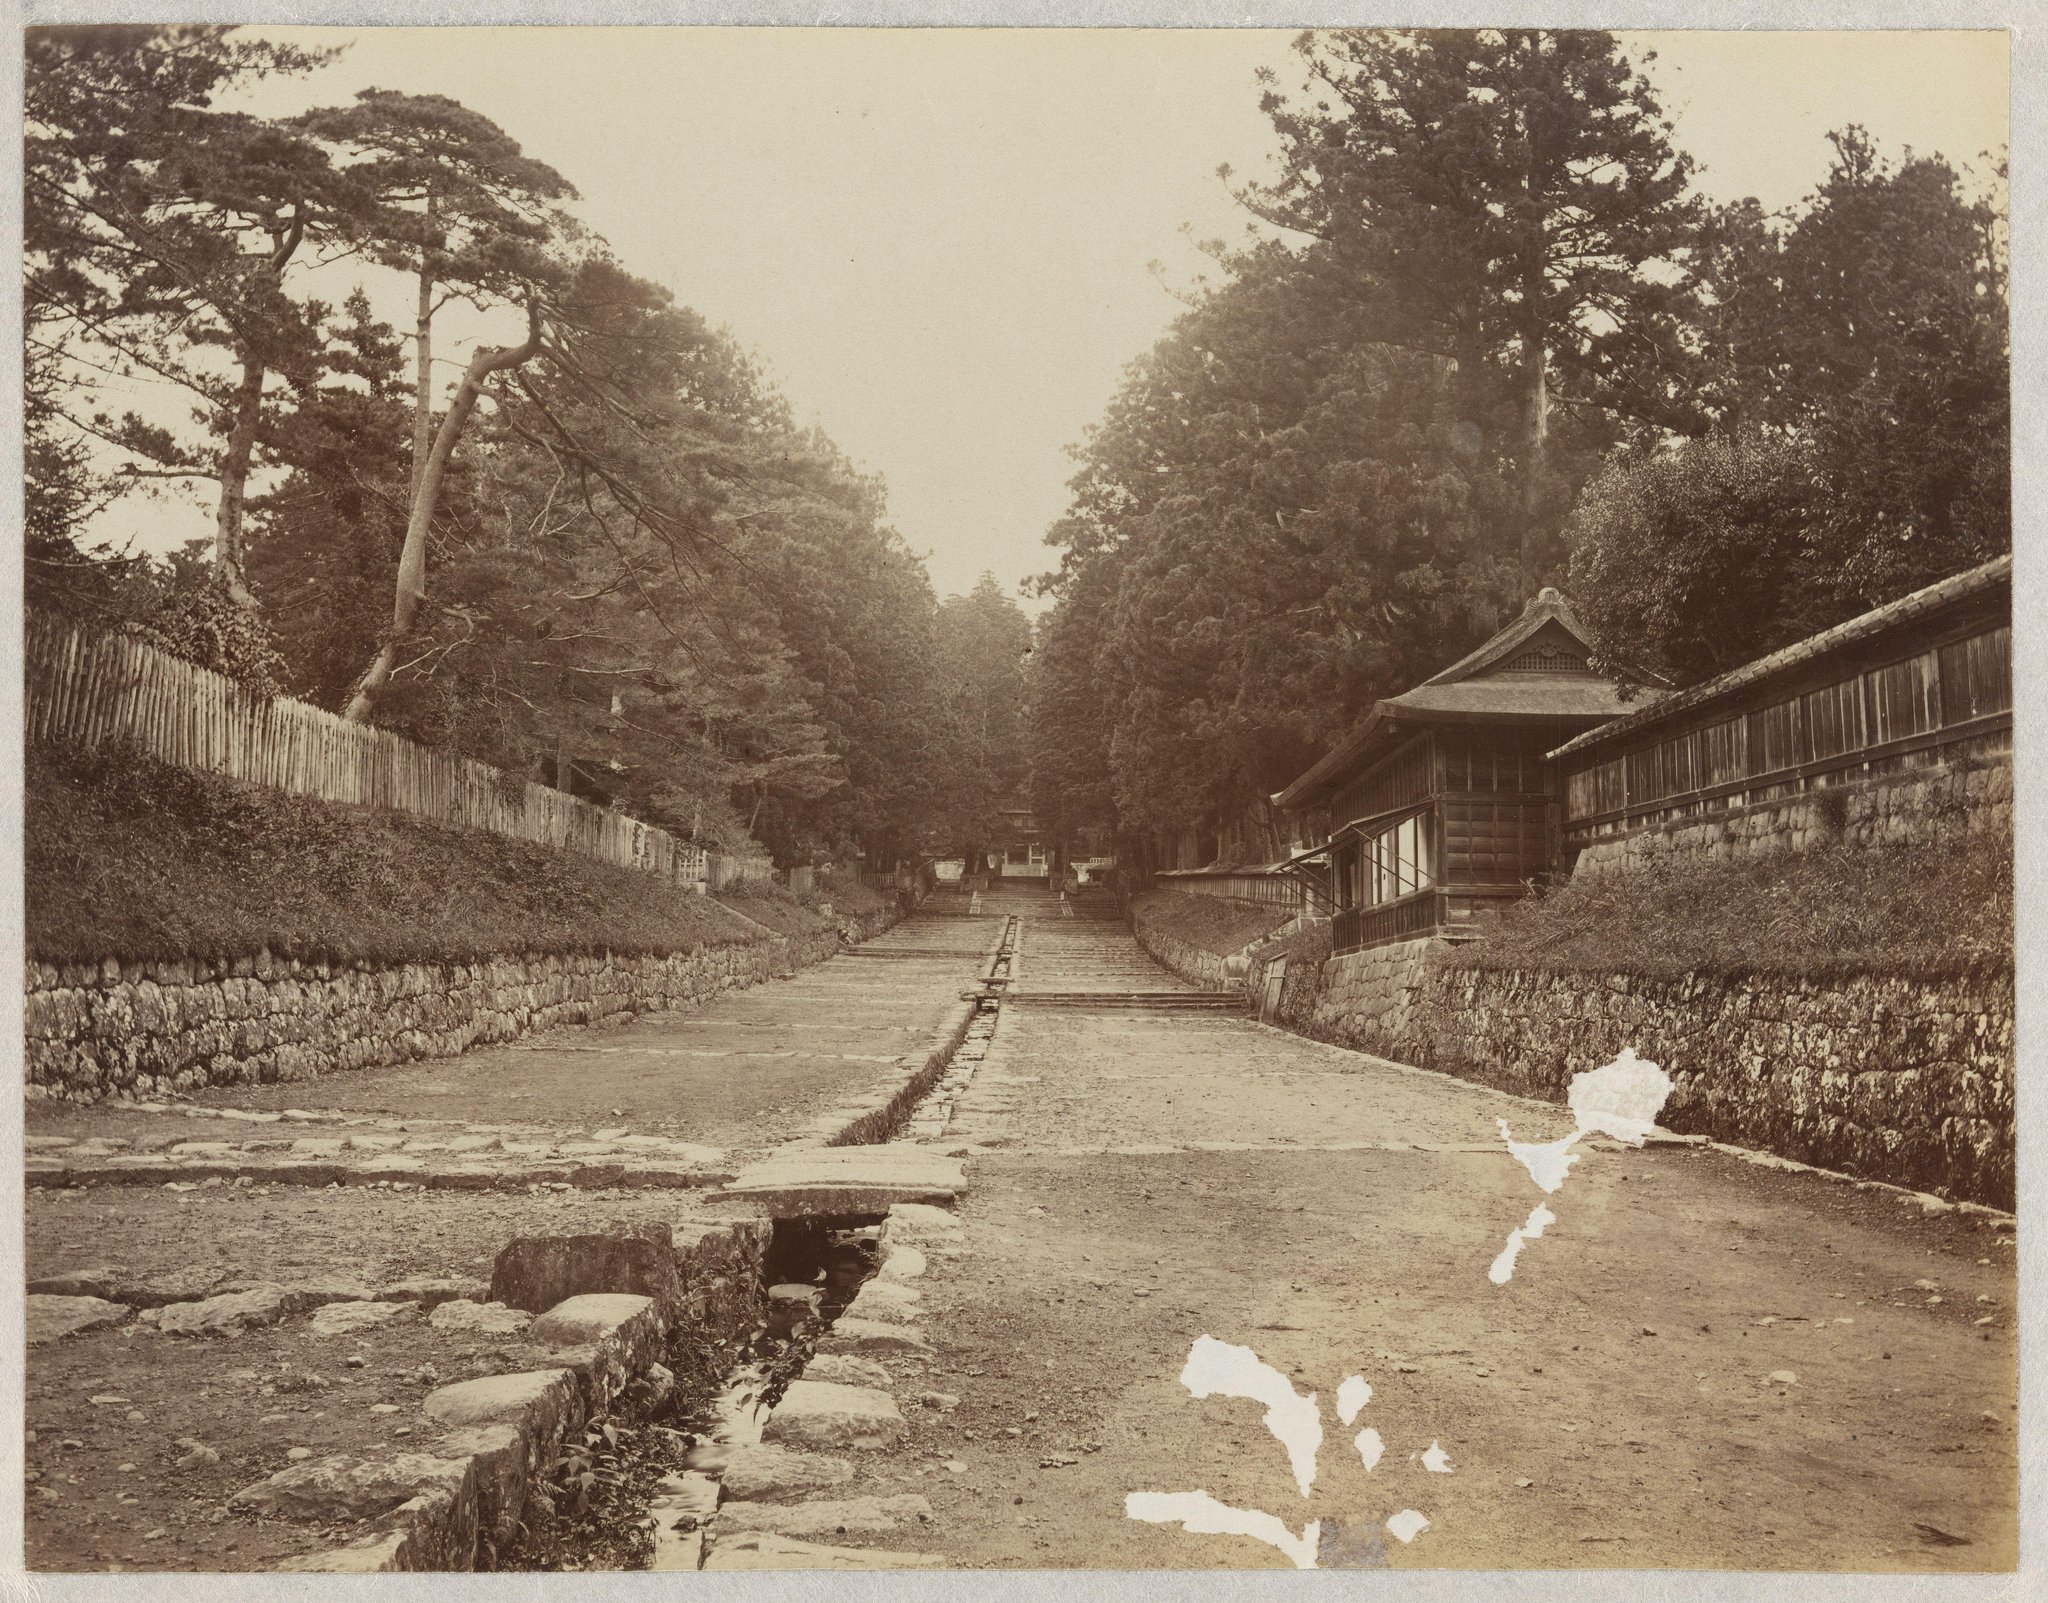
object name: photograph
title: City Hall, Hong Kong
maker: Anonymous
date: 1865-1875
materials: paper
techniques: albumen print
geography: hong kong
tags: hong kong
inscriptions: number: ‘184’, number: ‘BD.156’, inscription: ‘... City Hall Hongkong’, number: ‘10’